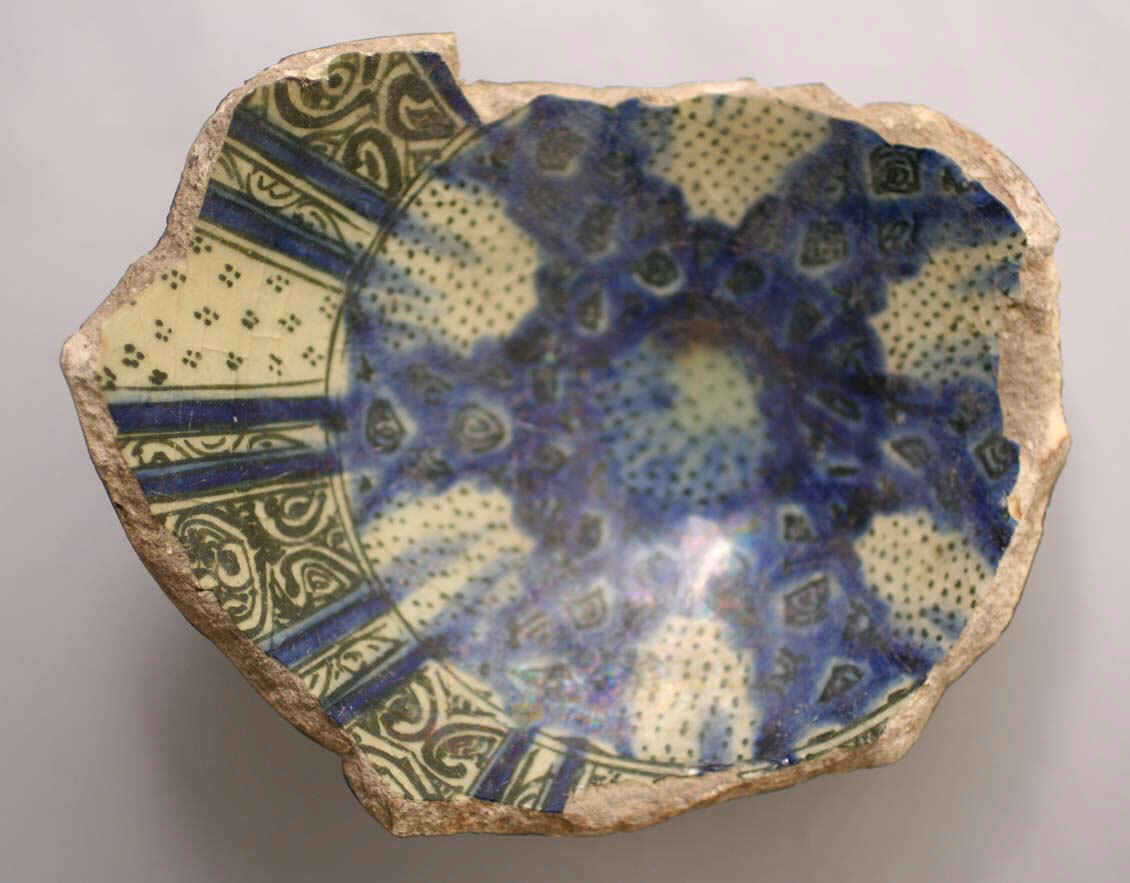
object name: fragment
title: Fragment of a Bowl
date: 1301-1400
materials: glaze, stonepaste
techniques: painting, polychrome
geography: syria